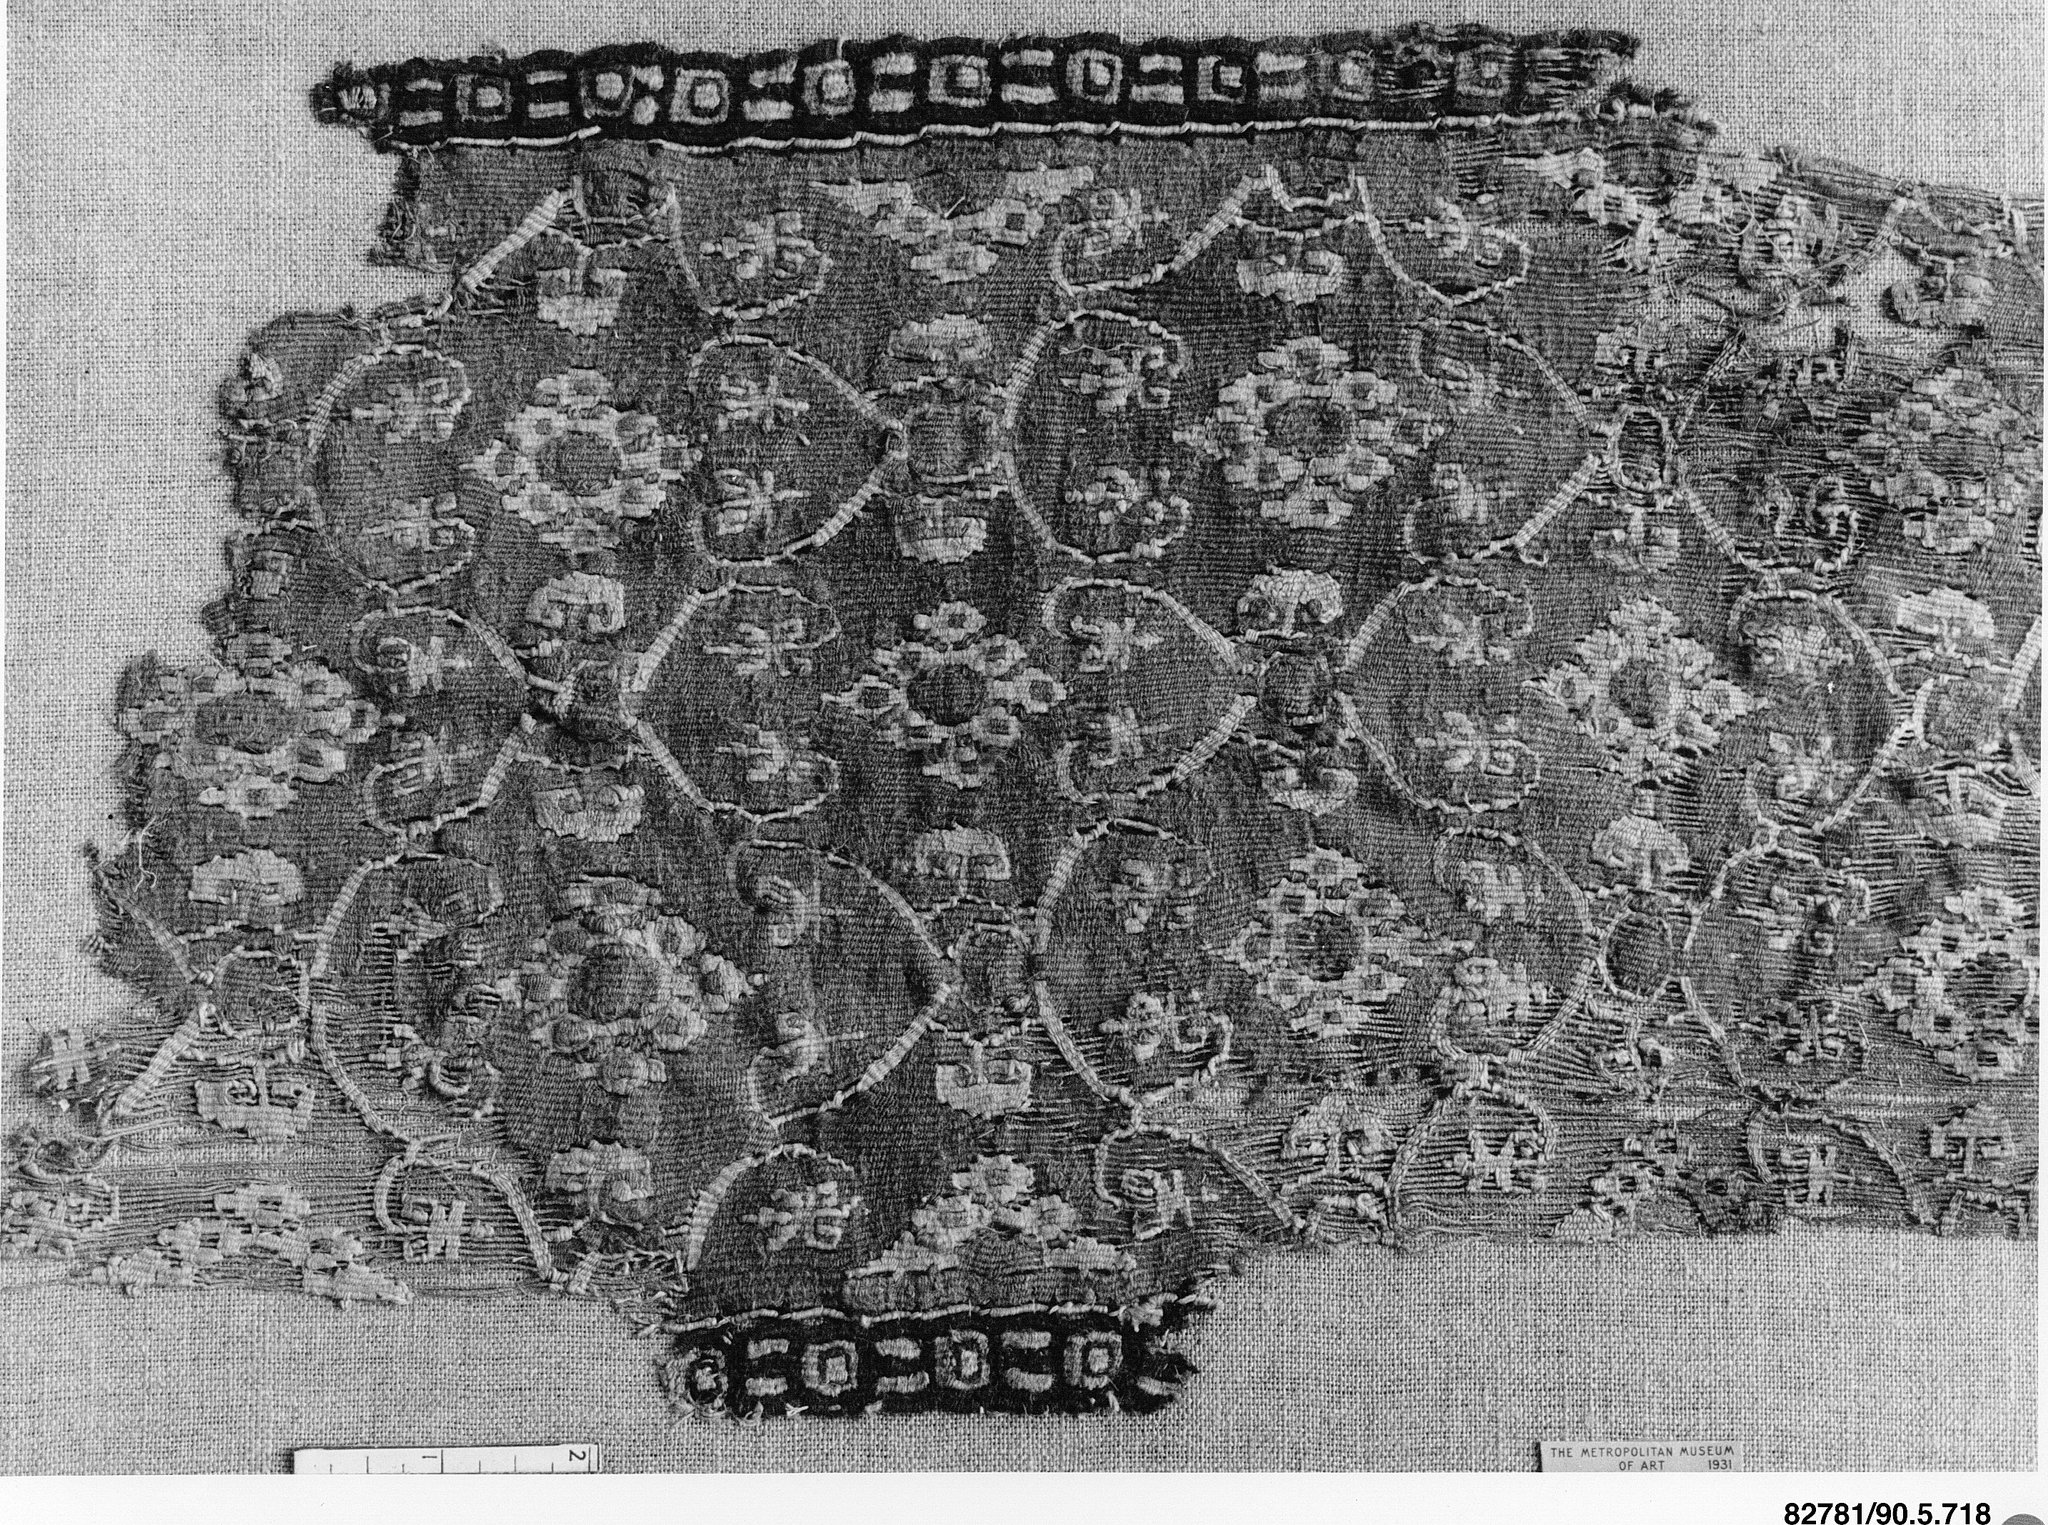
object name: textile fragment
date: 401-600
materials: linen, wool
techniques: weave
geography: egypt